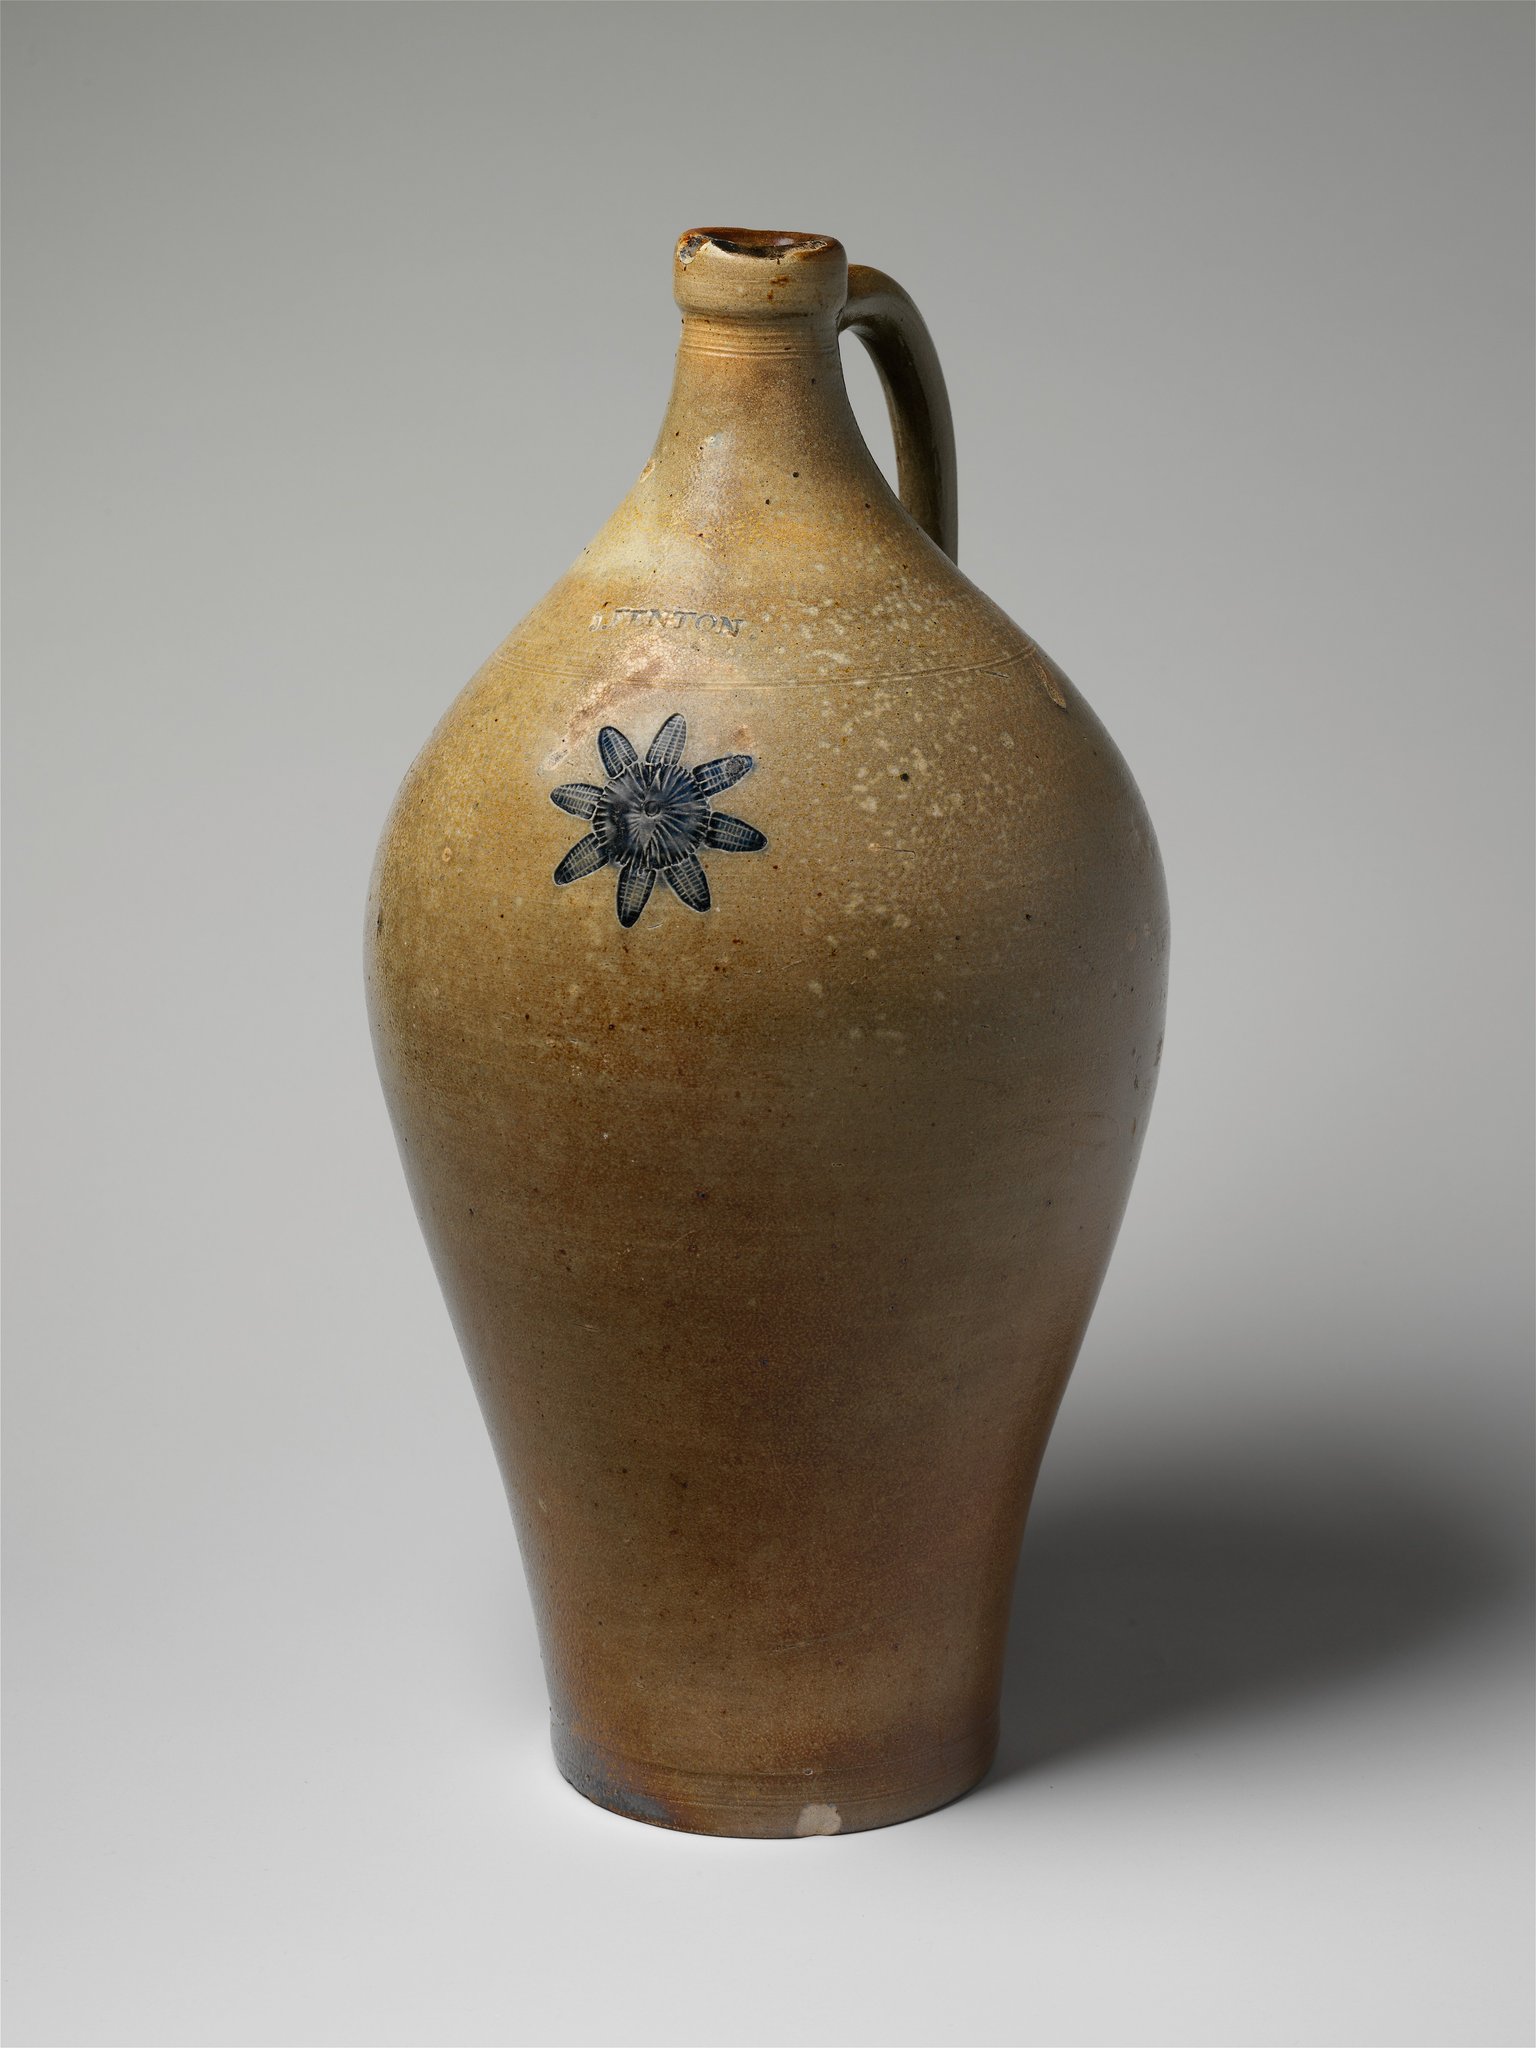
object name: jug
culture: american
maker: jonathan fenton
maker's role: maker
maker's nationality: american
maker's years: 1766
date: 1810-1835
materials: stoneware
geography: united states